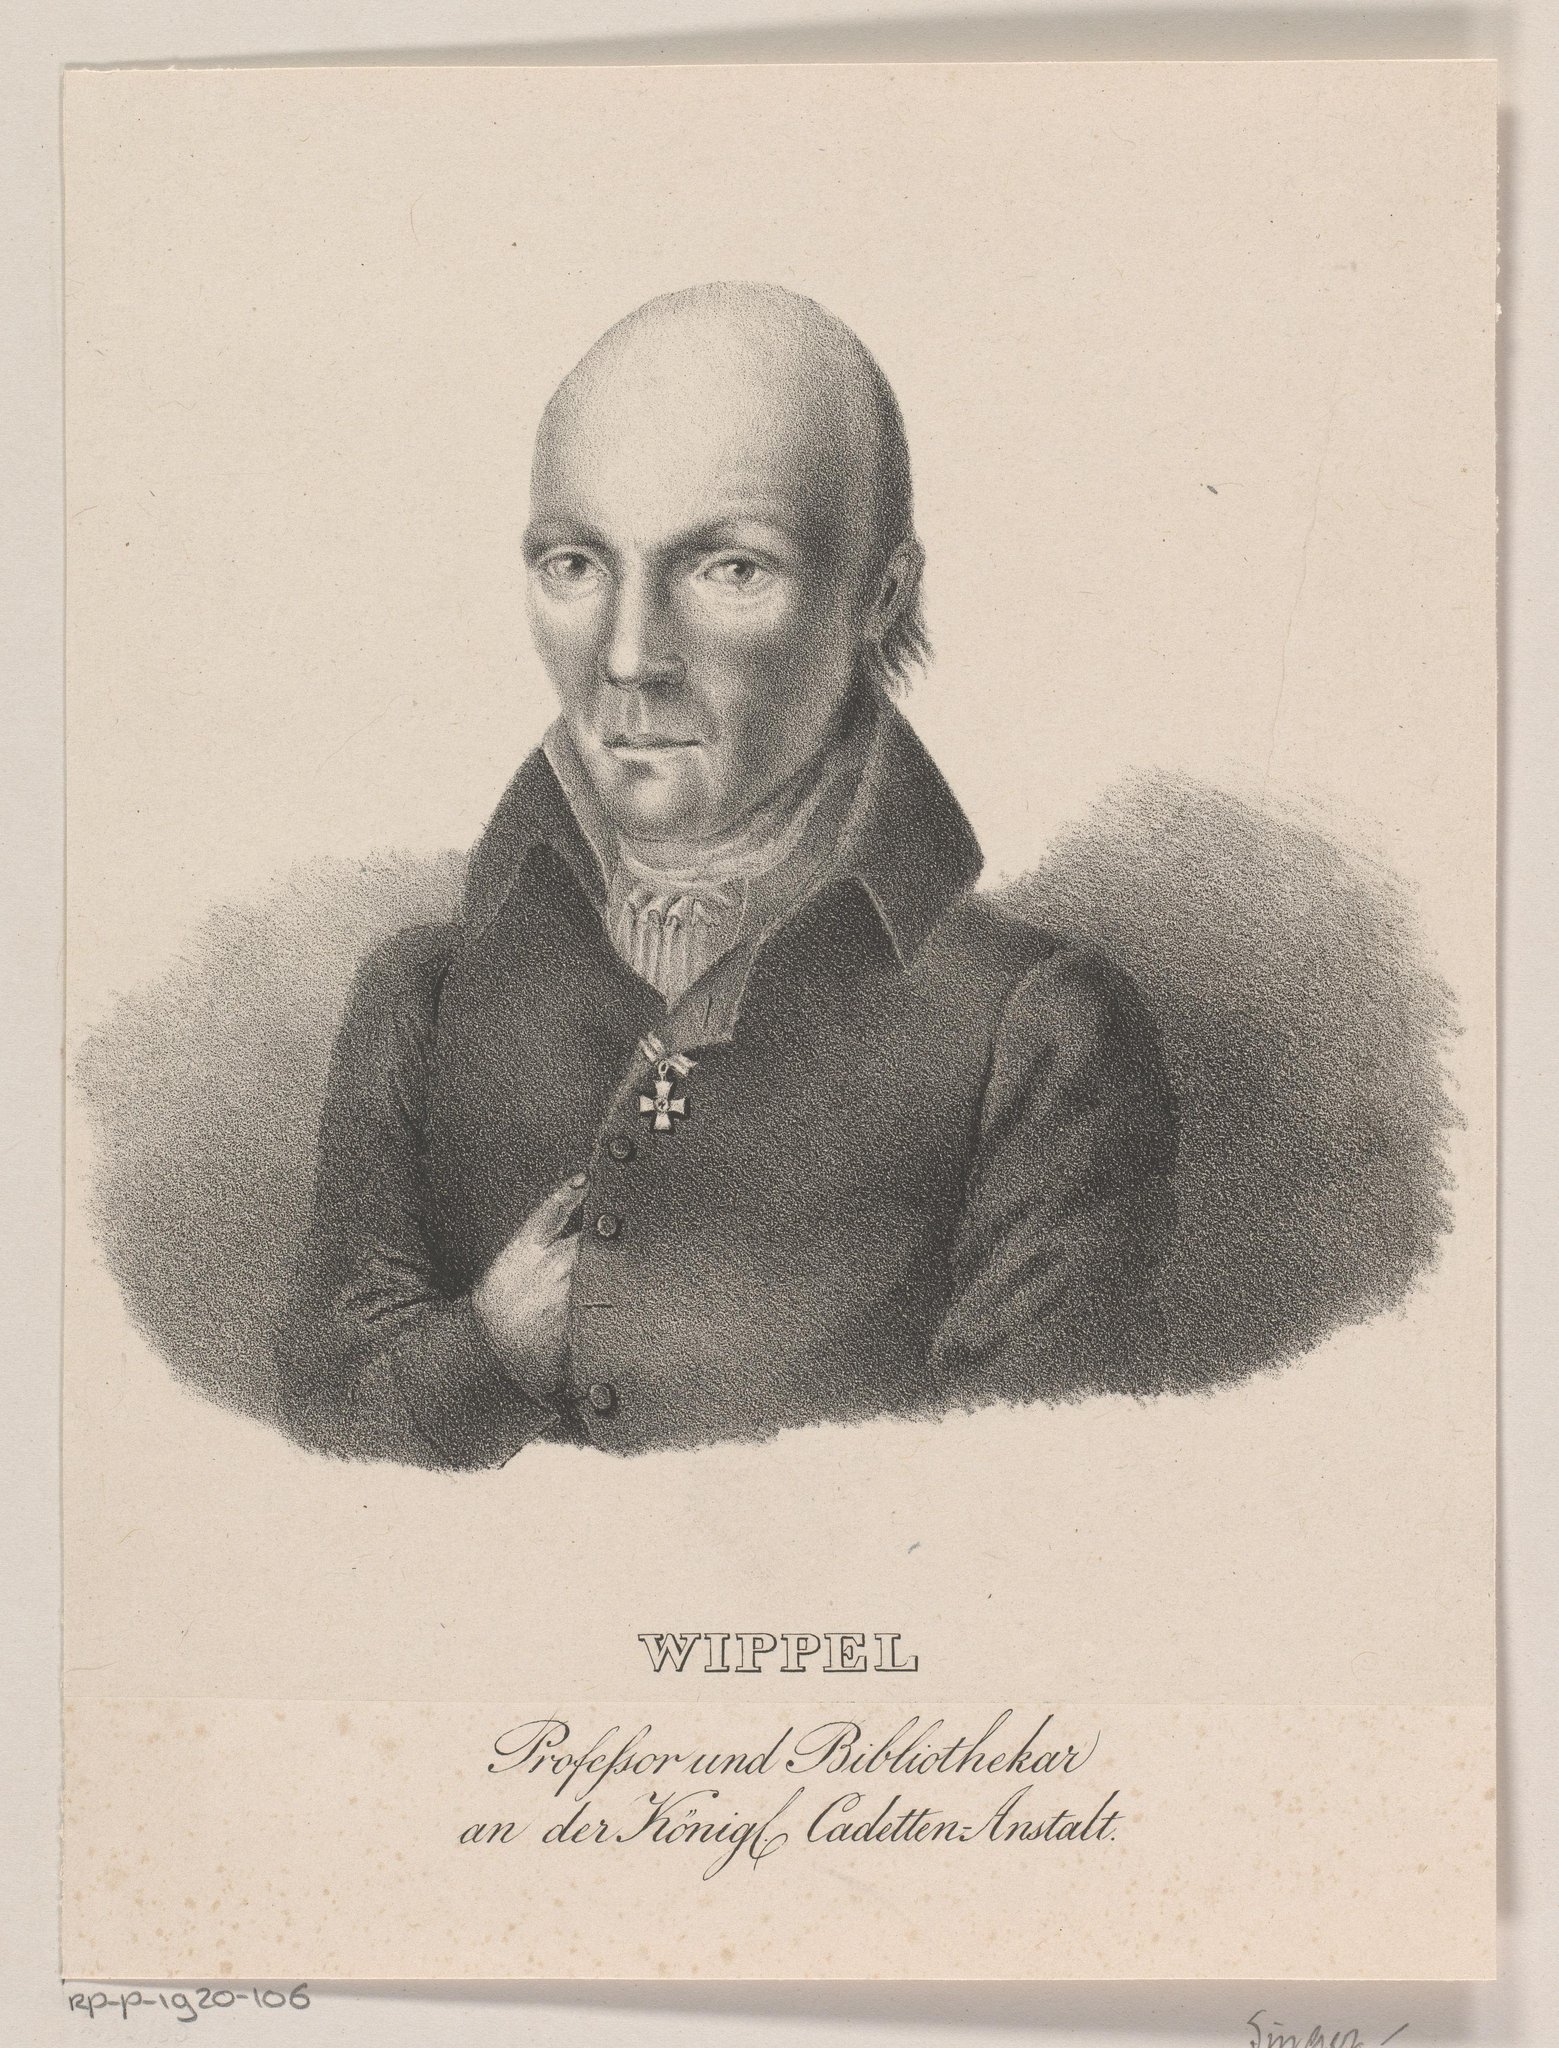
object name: print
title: Portret van Wilhelm Jakob Wippel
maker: Anonymous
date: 1798-1834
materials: paper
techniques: lithograph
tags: berlin, historical persons, professor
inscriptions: collector's mark: Lugt 2228